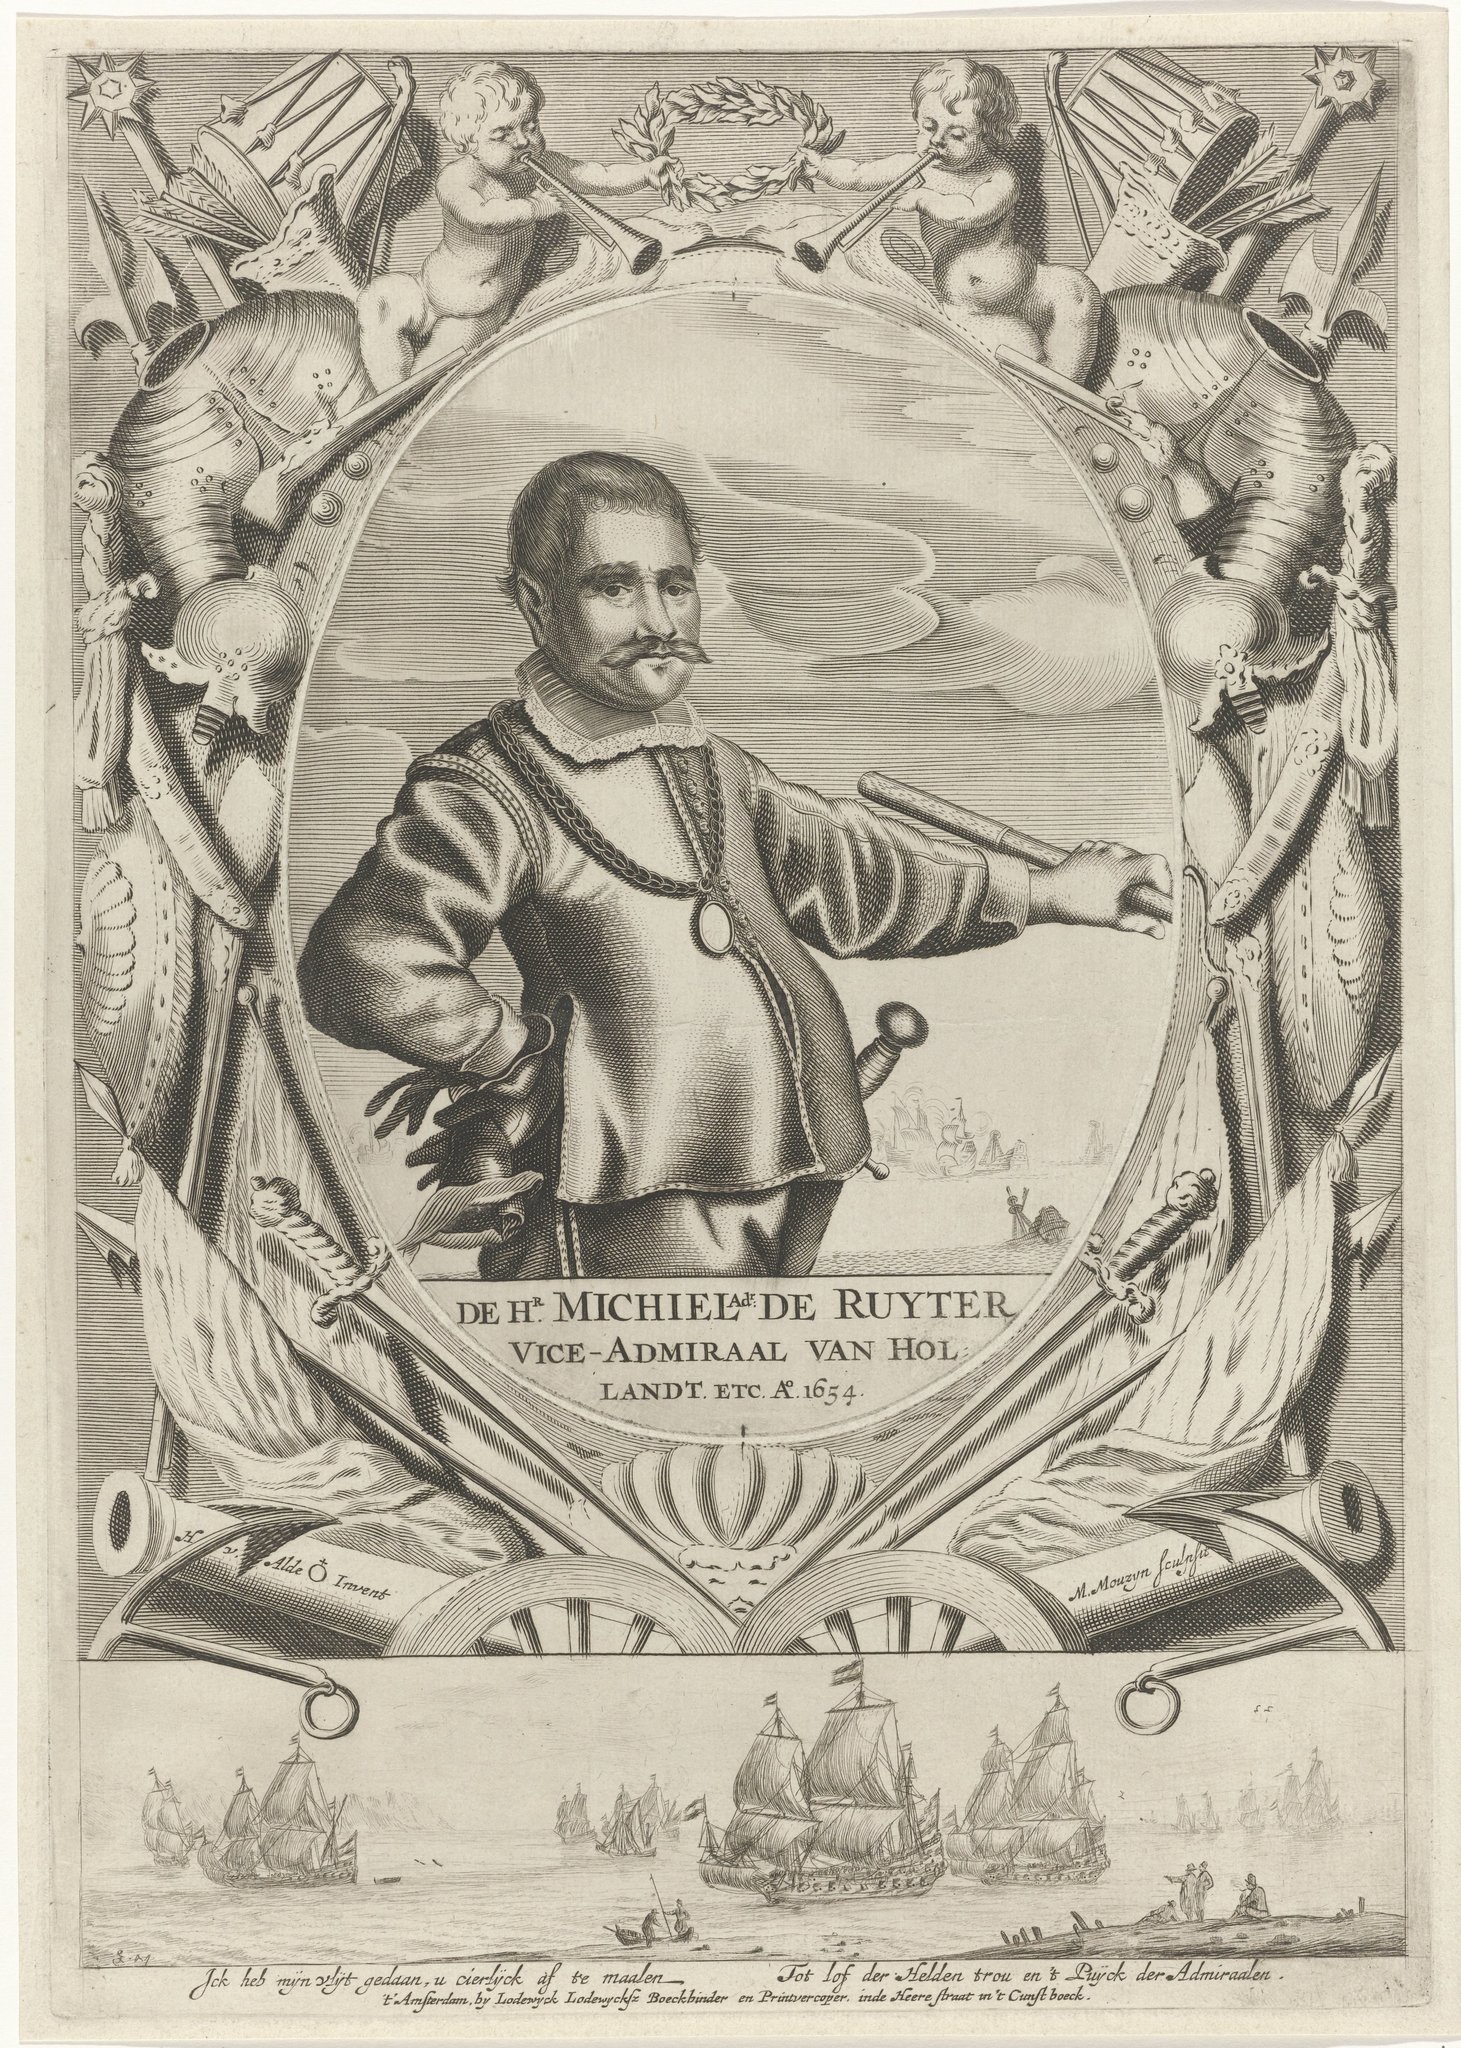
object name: print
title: Portret van Michiel Adriaenszoon de Ruyter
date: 1640-1655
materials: paper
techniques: engraving, etching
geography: amsterdam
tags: michiel adriaenszoon de ruyter, navy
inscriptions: collector's mark: Lugt 2228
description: Portret van admiraal Michiel Adriaenszoon de Ruyter, in zijn hand de bevelhebberstaf. Het portret is gevat in ornamentele lijst met vlaggen, zwaarden, kanonnen, harnasdelen en wordt bekroond door twee putti, die een lauwerkrans ophouden. Onderaan in de marge een zeegezicht met zeilschepen.